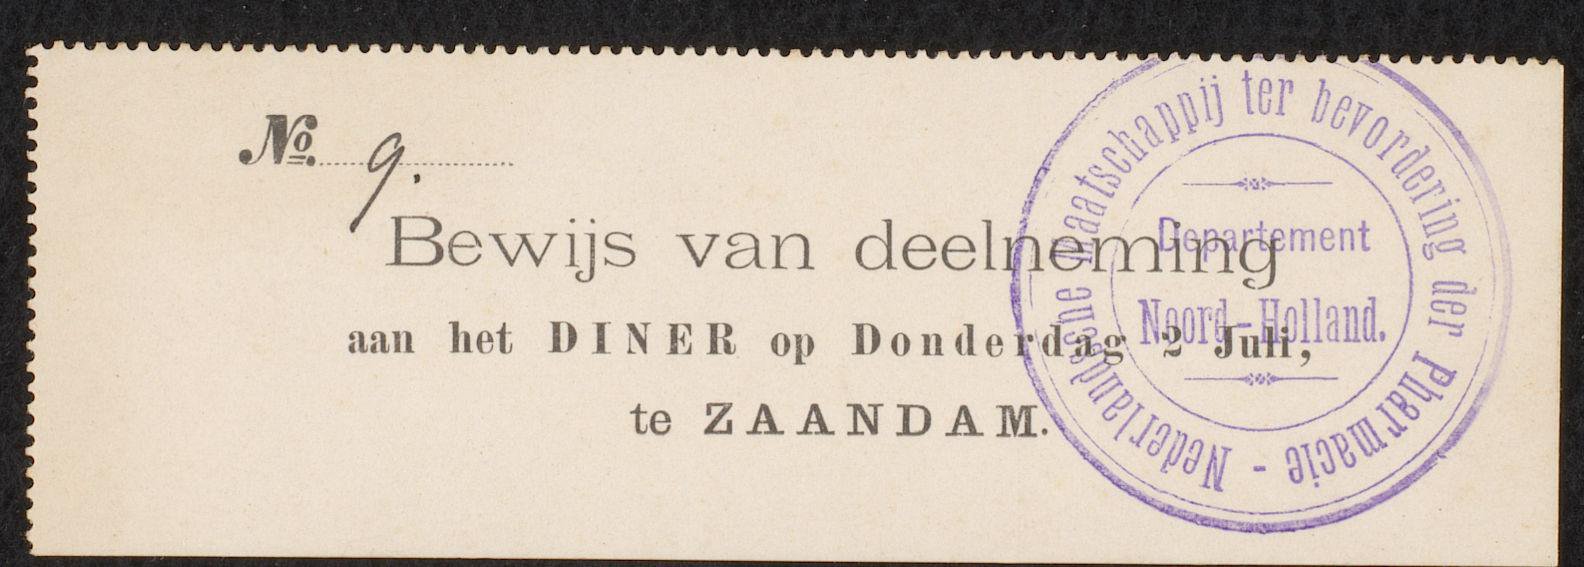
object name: text sheet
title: Bewijs van deelneming aan het diner van de Nederlandsche Maatschappij ter Bevordering der Pharmacie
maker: Anonymous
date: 1842-1890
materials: paper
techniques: letterpress printing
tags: printed matter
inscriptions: stamp: ‘Nederlandsche Maatschappij ter bevordering der Pharmacie’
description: Kaartje met getande linker- en bovenrand. Met de tekst: 'Bewijs van deelneming aan het diner op Donderdag 2 Juli, te Zaandam'. Daarboven nog een regel voor een nummer, waar met de hand het cijfer negen is ingevuld.